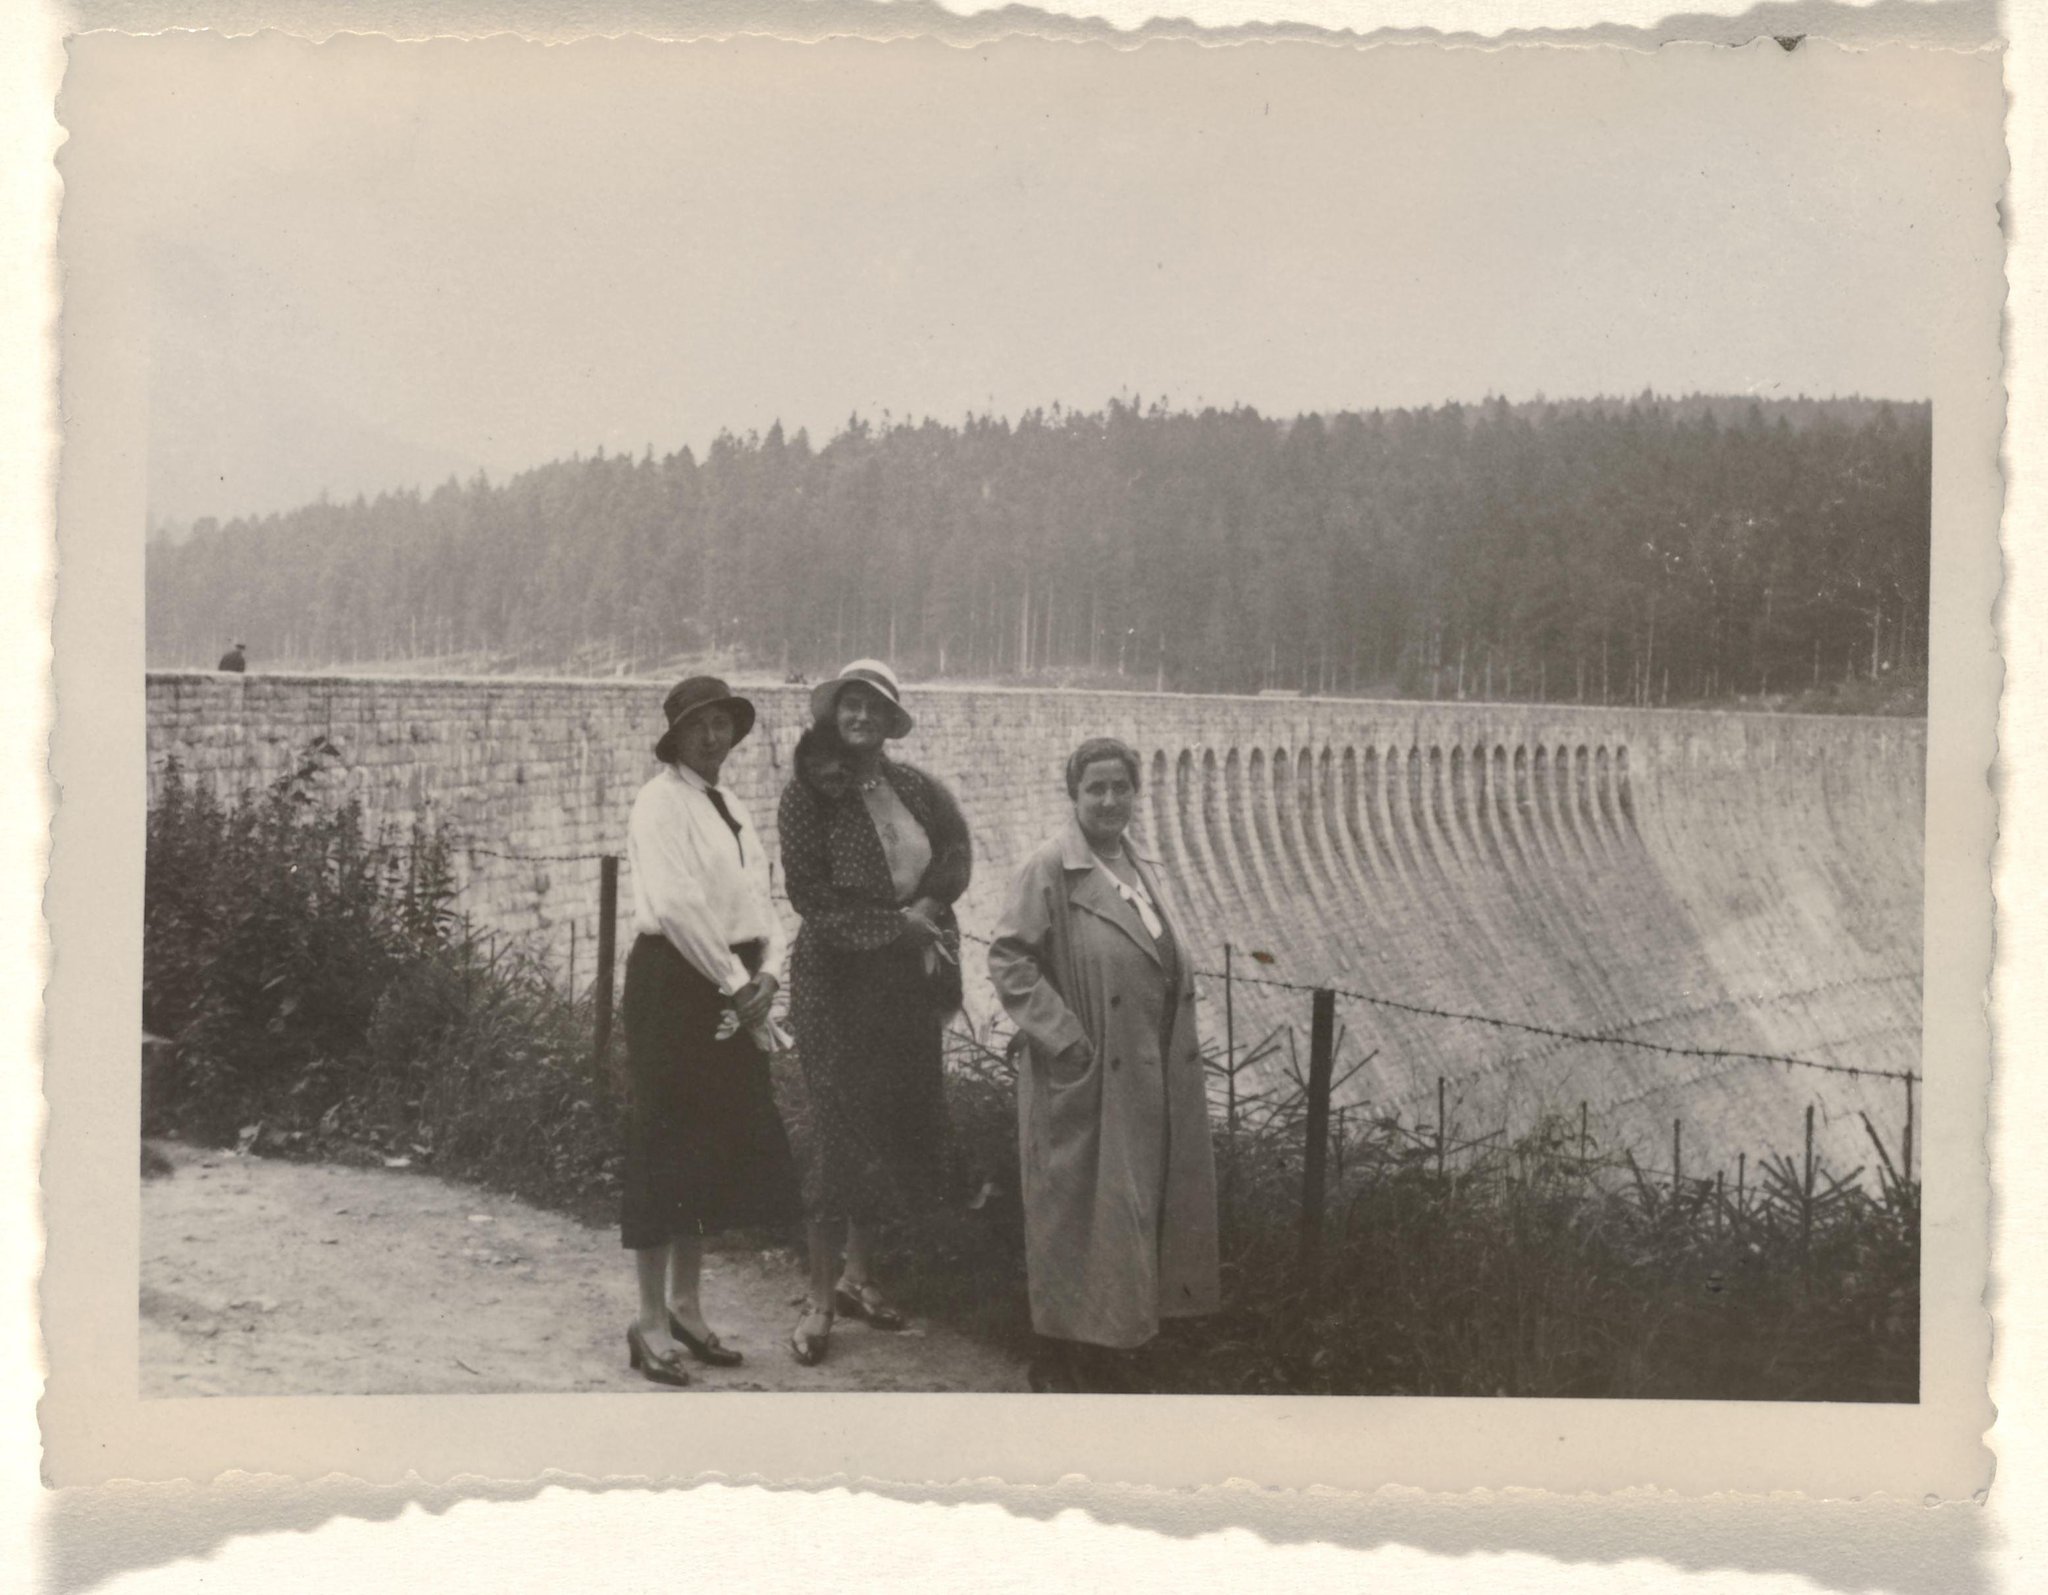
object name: photograph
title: Else Wachenheimer-Moos en twee onbekende vrouwen met hoeden op voor een hek bij een grote betonnen constructie met bomen op de achtergrond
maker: Anonymous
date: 1908-1932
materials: photographic support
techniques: gelatin silver print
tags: else wachenheimer-moos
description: Else Wachenheimer-Moos (rechts) en twee onbekende vrouwen met hoeden op voor een hek bij een grote betonnen constructie met bomen op de achtergrond.